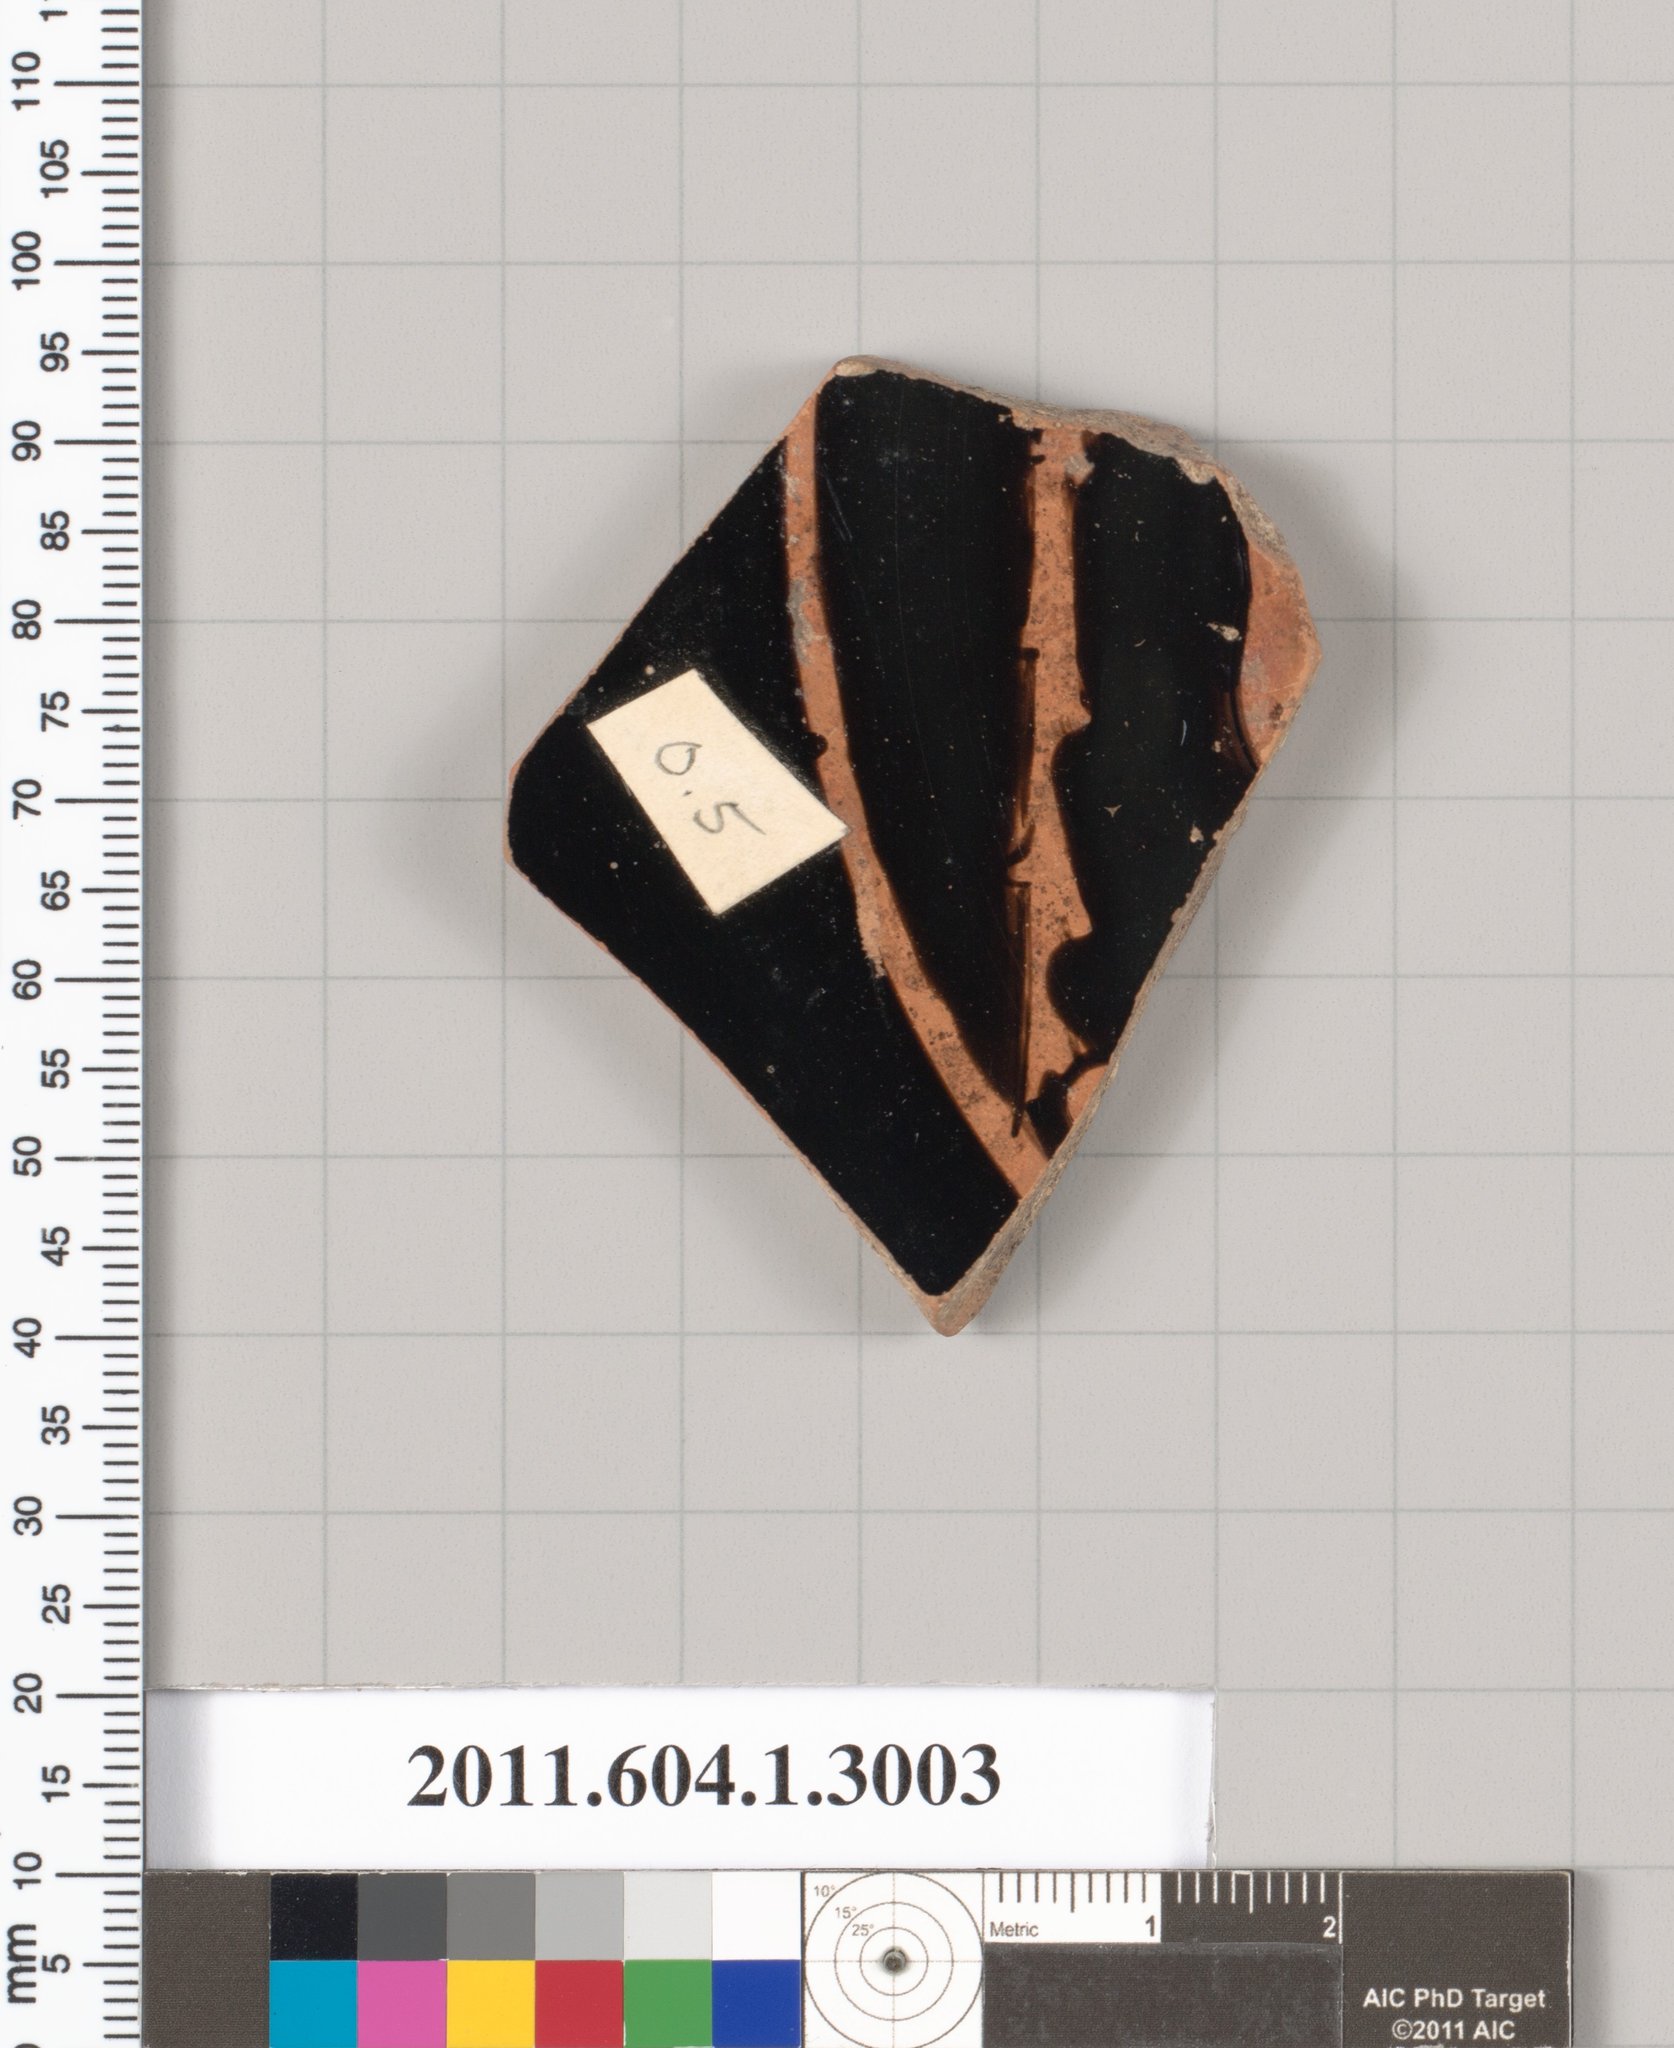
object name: kylix fragment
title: Terracotta fragment of a kylix (drinking cup)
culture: greek, attic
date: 500-476 BCE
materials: terracotta